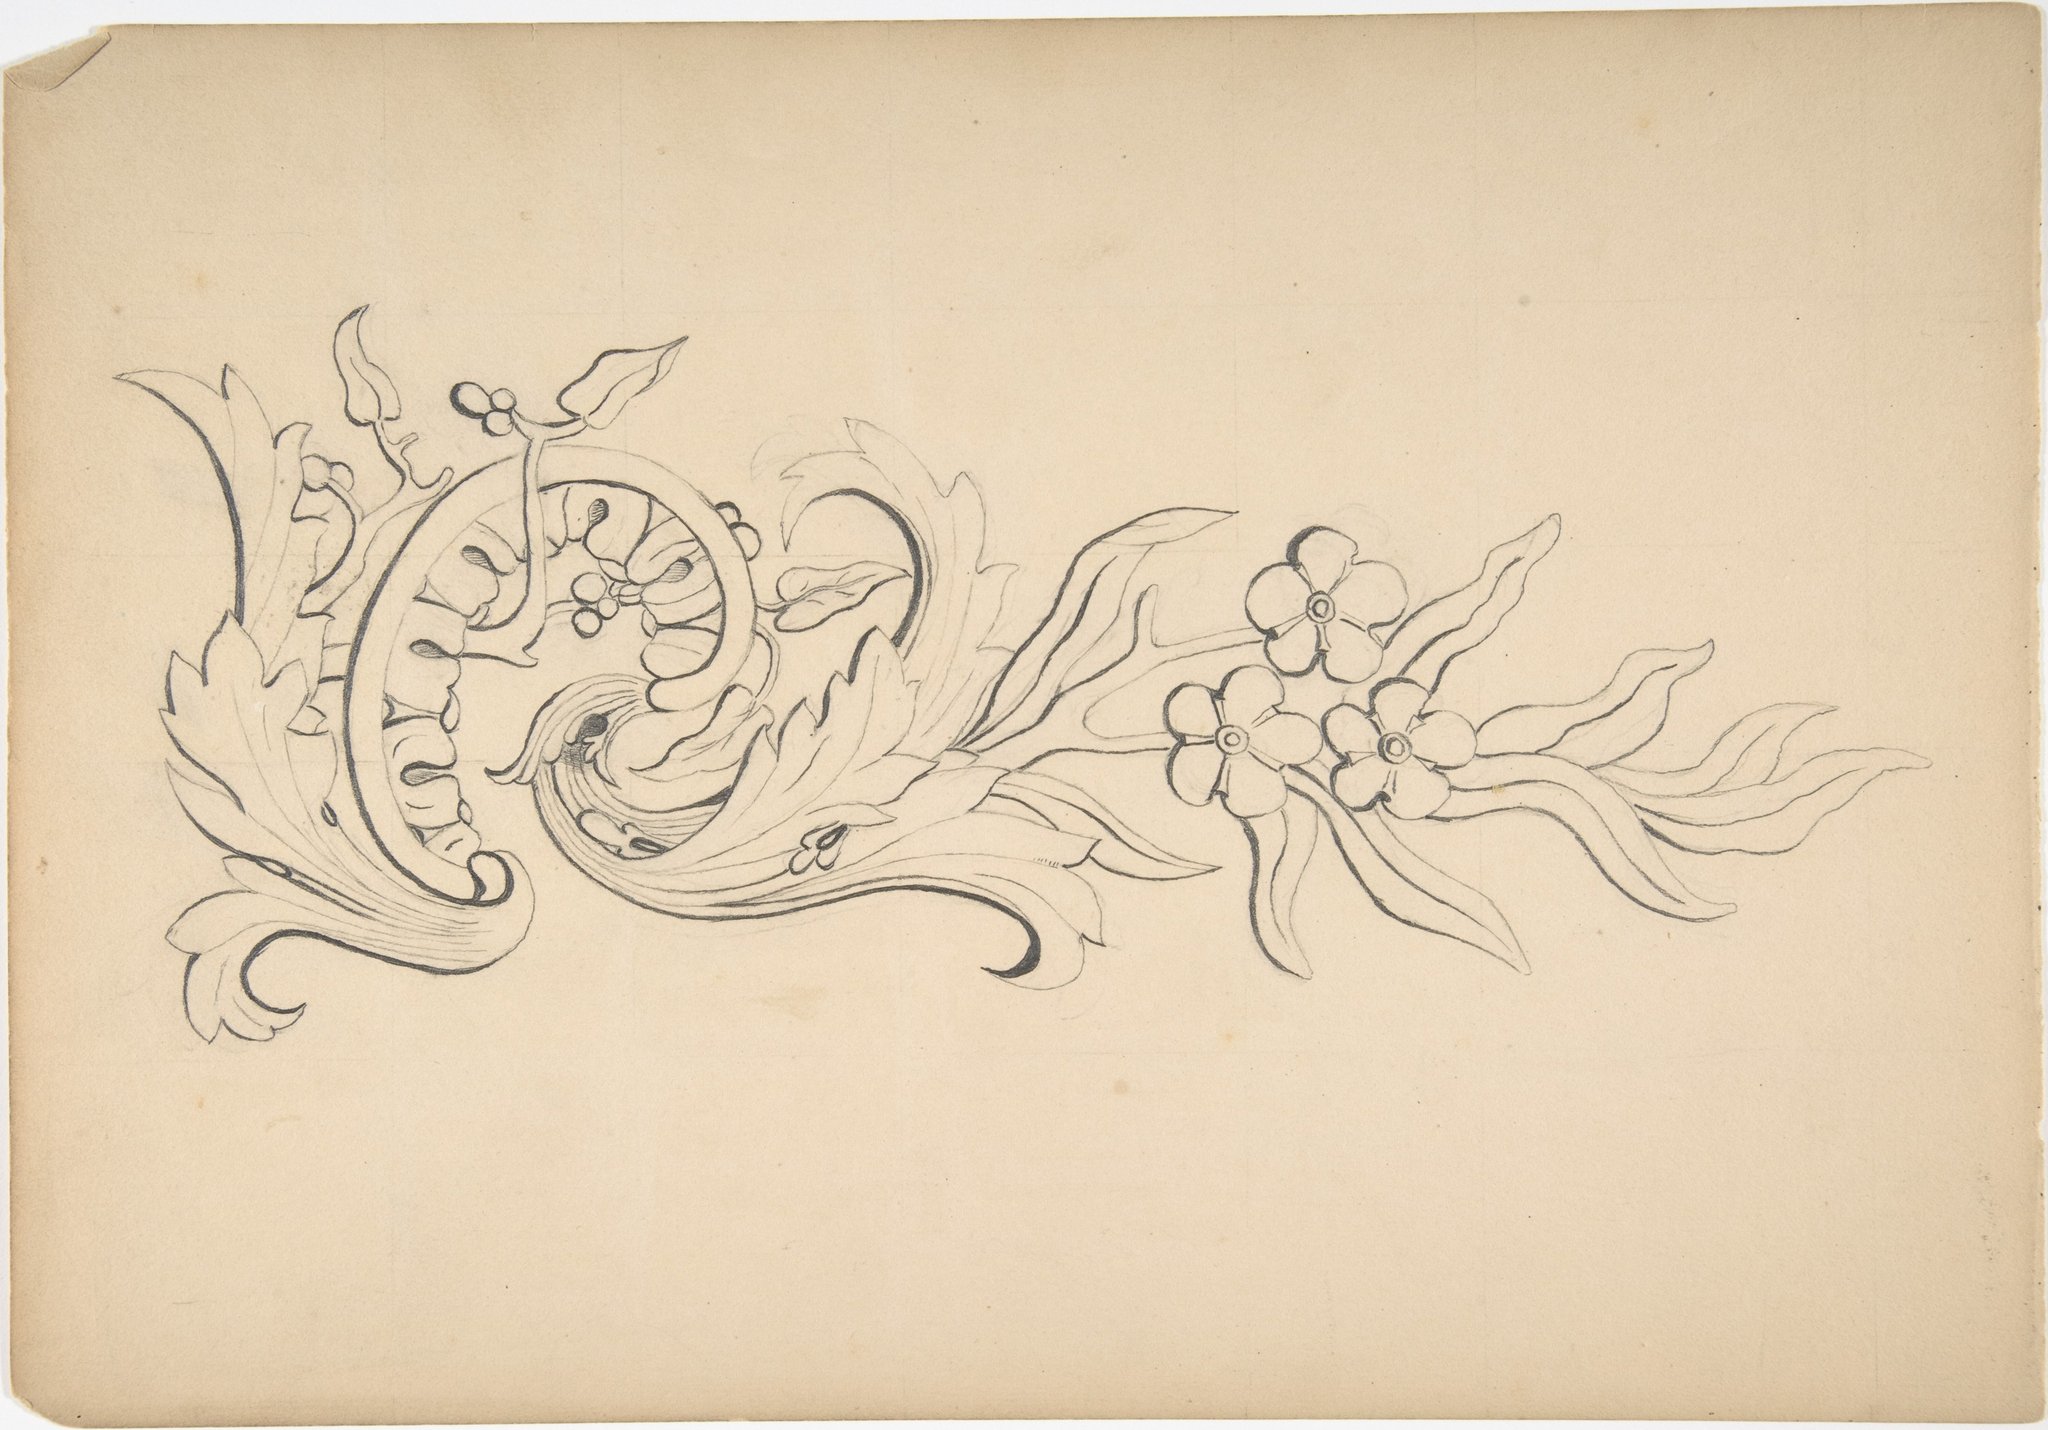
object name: drawing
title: Designs for borders and corners, acanthus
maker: robert william hume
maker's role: artist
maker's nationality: british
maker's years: 1816-1904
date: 1830-1904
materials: graphite, ink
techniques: pen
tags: flowers,leaves